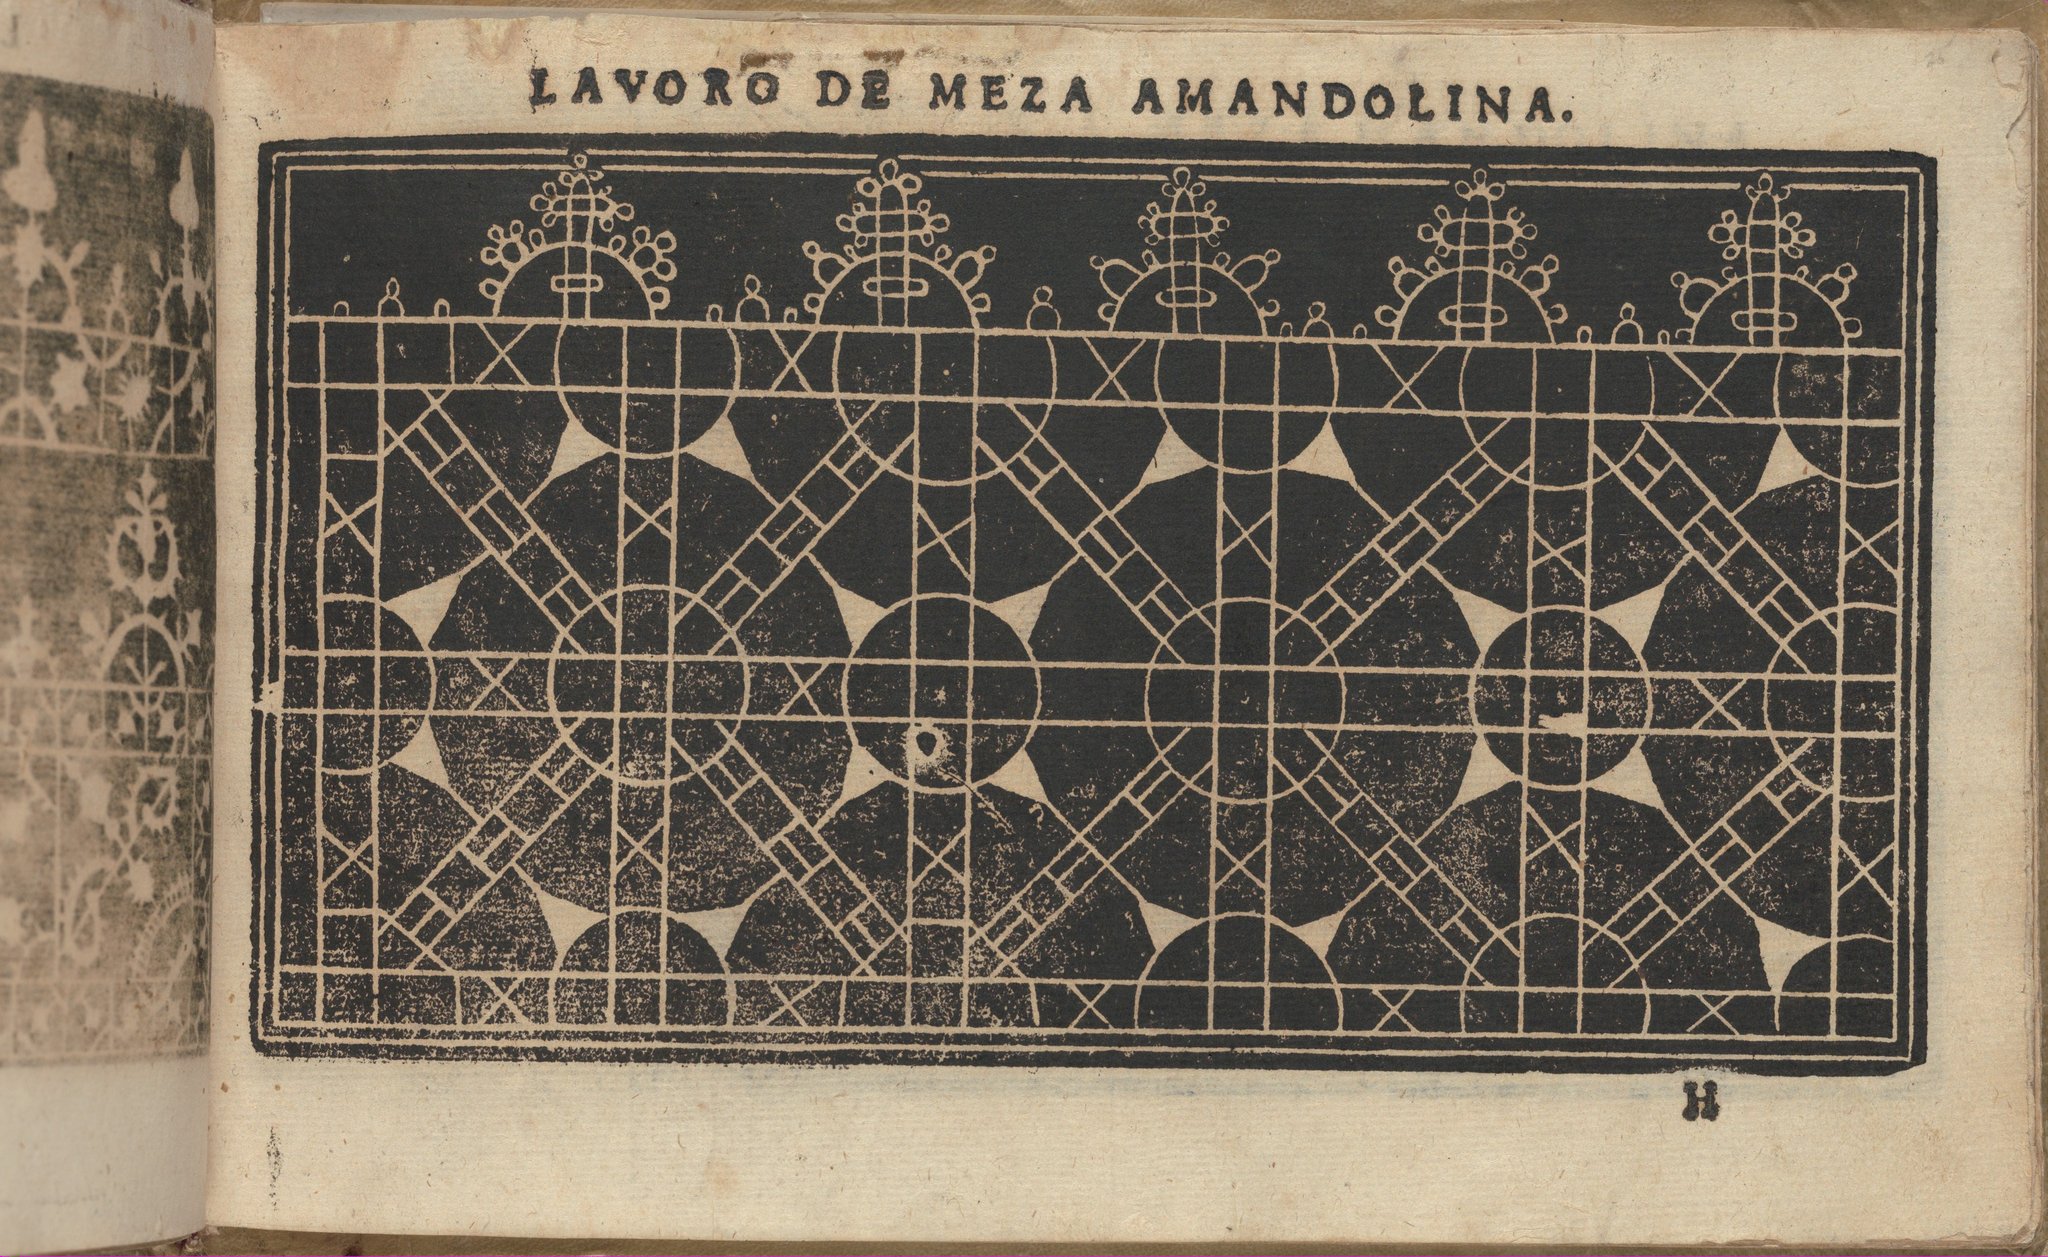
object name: book print ornament architecture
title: Studio delle virtuose Dame, page 25 (recto)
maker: isabella catanea parasole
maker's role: designer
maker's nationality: italian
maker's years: 1565-1625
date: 1597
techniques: woodcut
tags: ornament